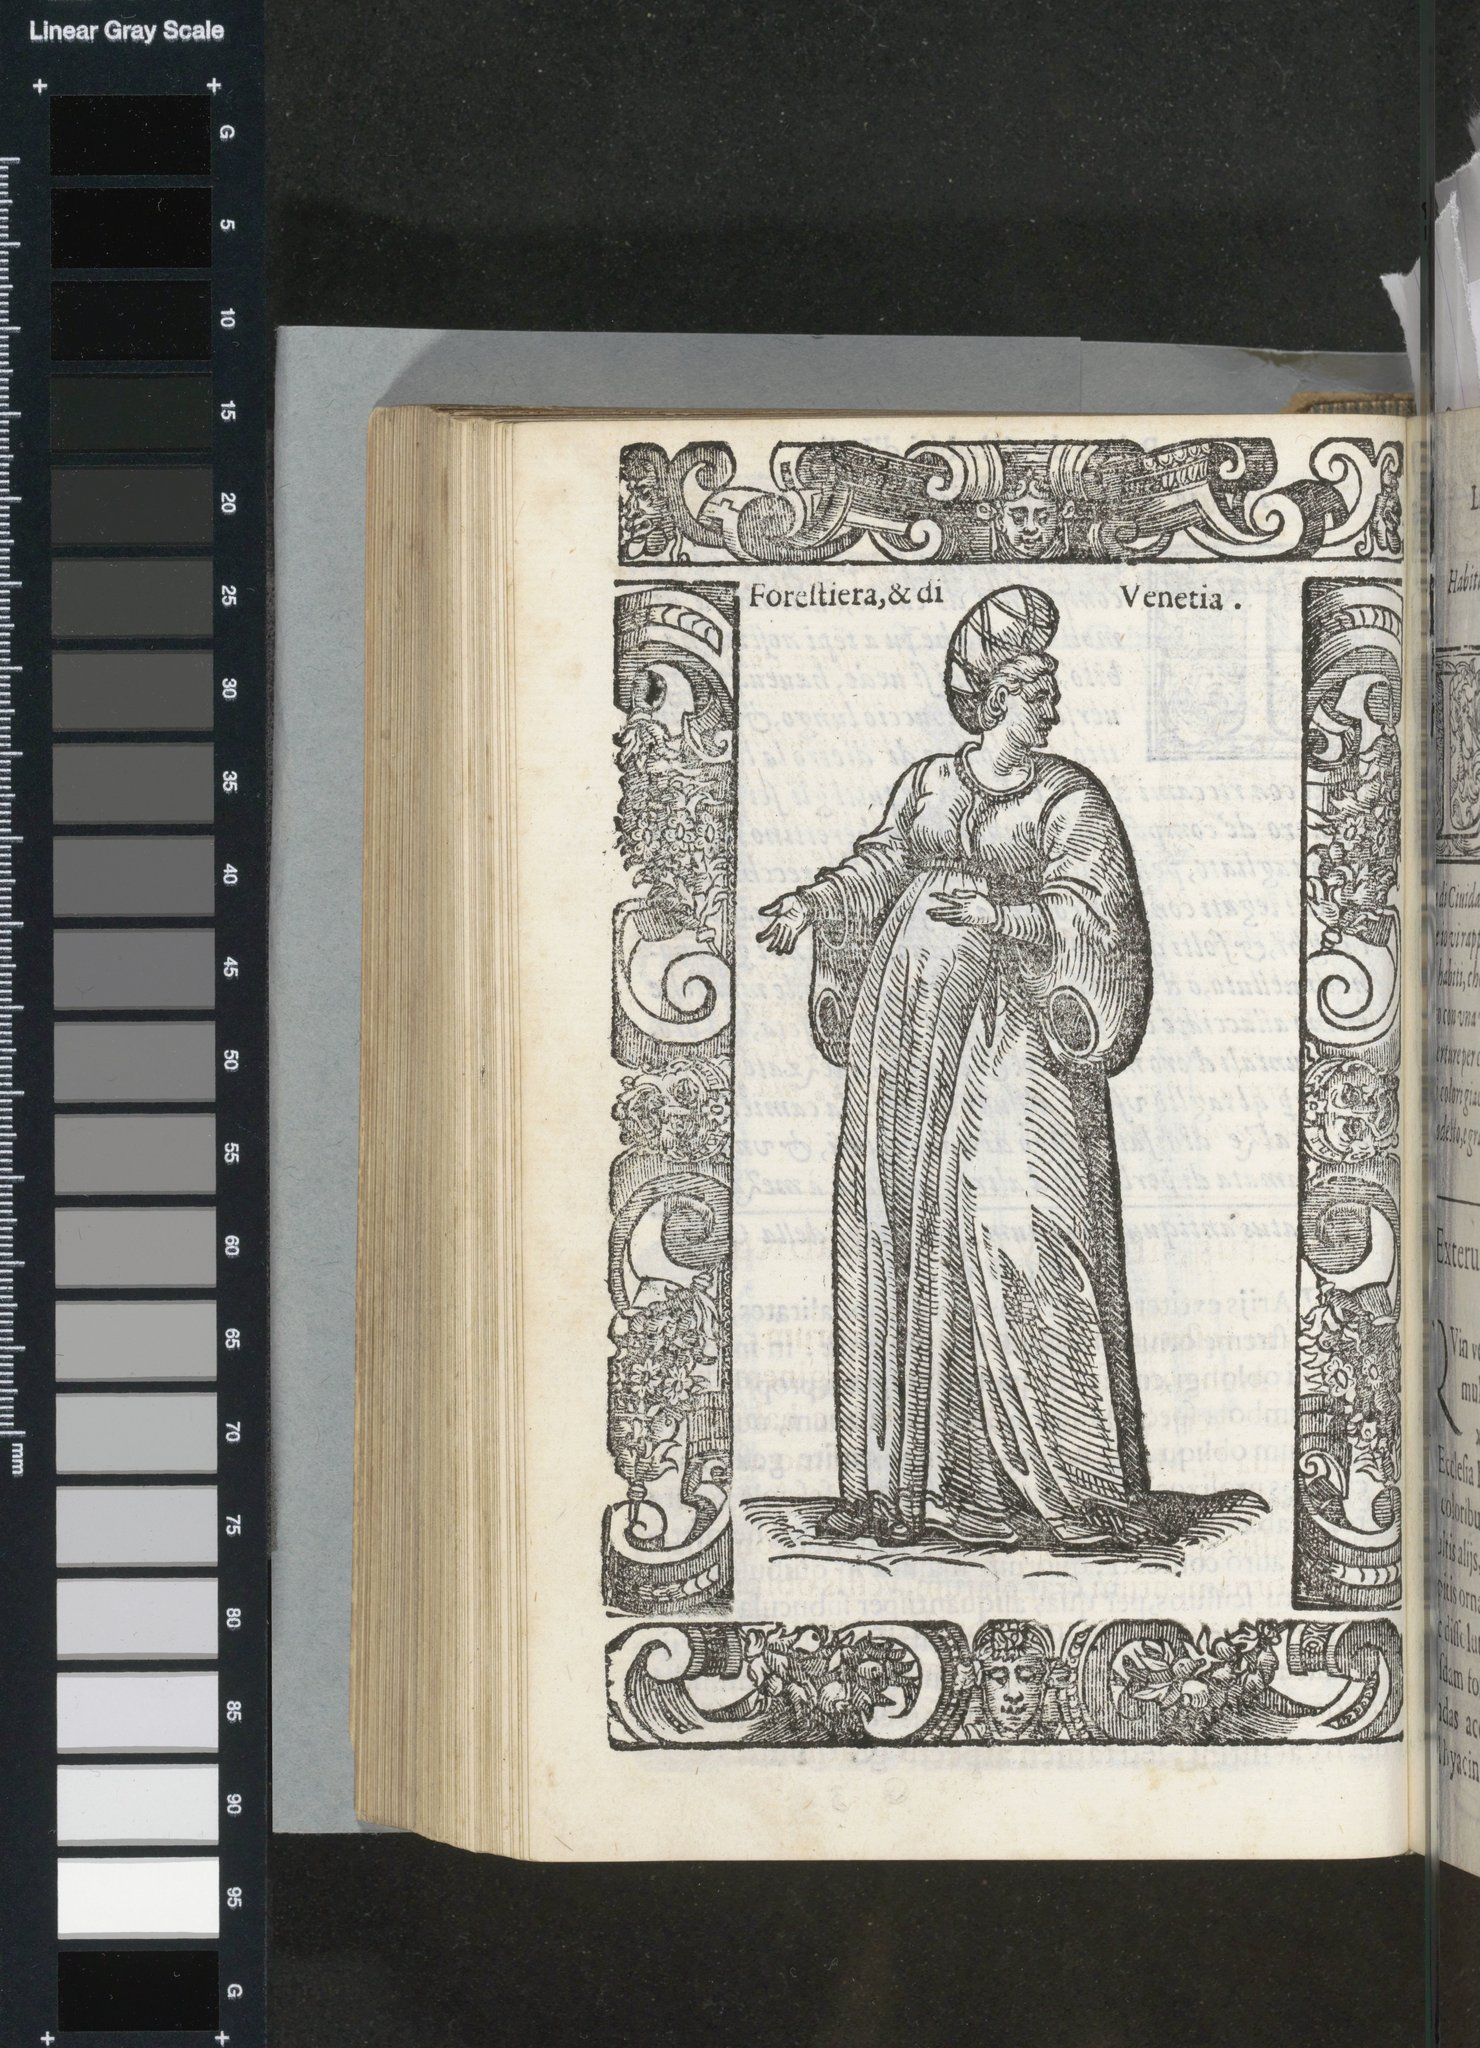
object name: costume print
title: Forestiera, & di venetia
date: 1598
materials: paper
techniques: woodcut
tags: fashion plates